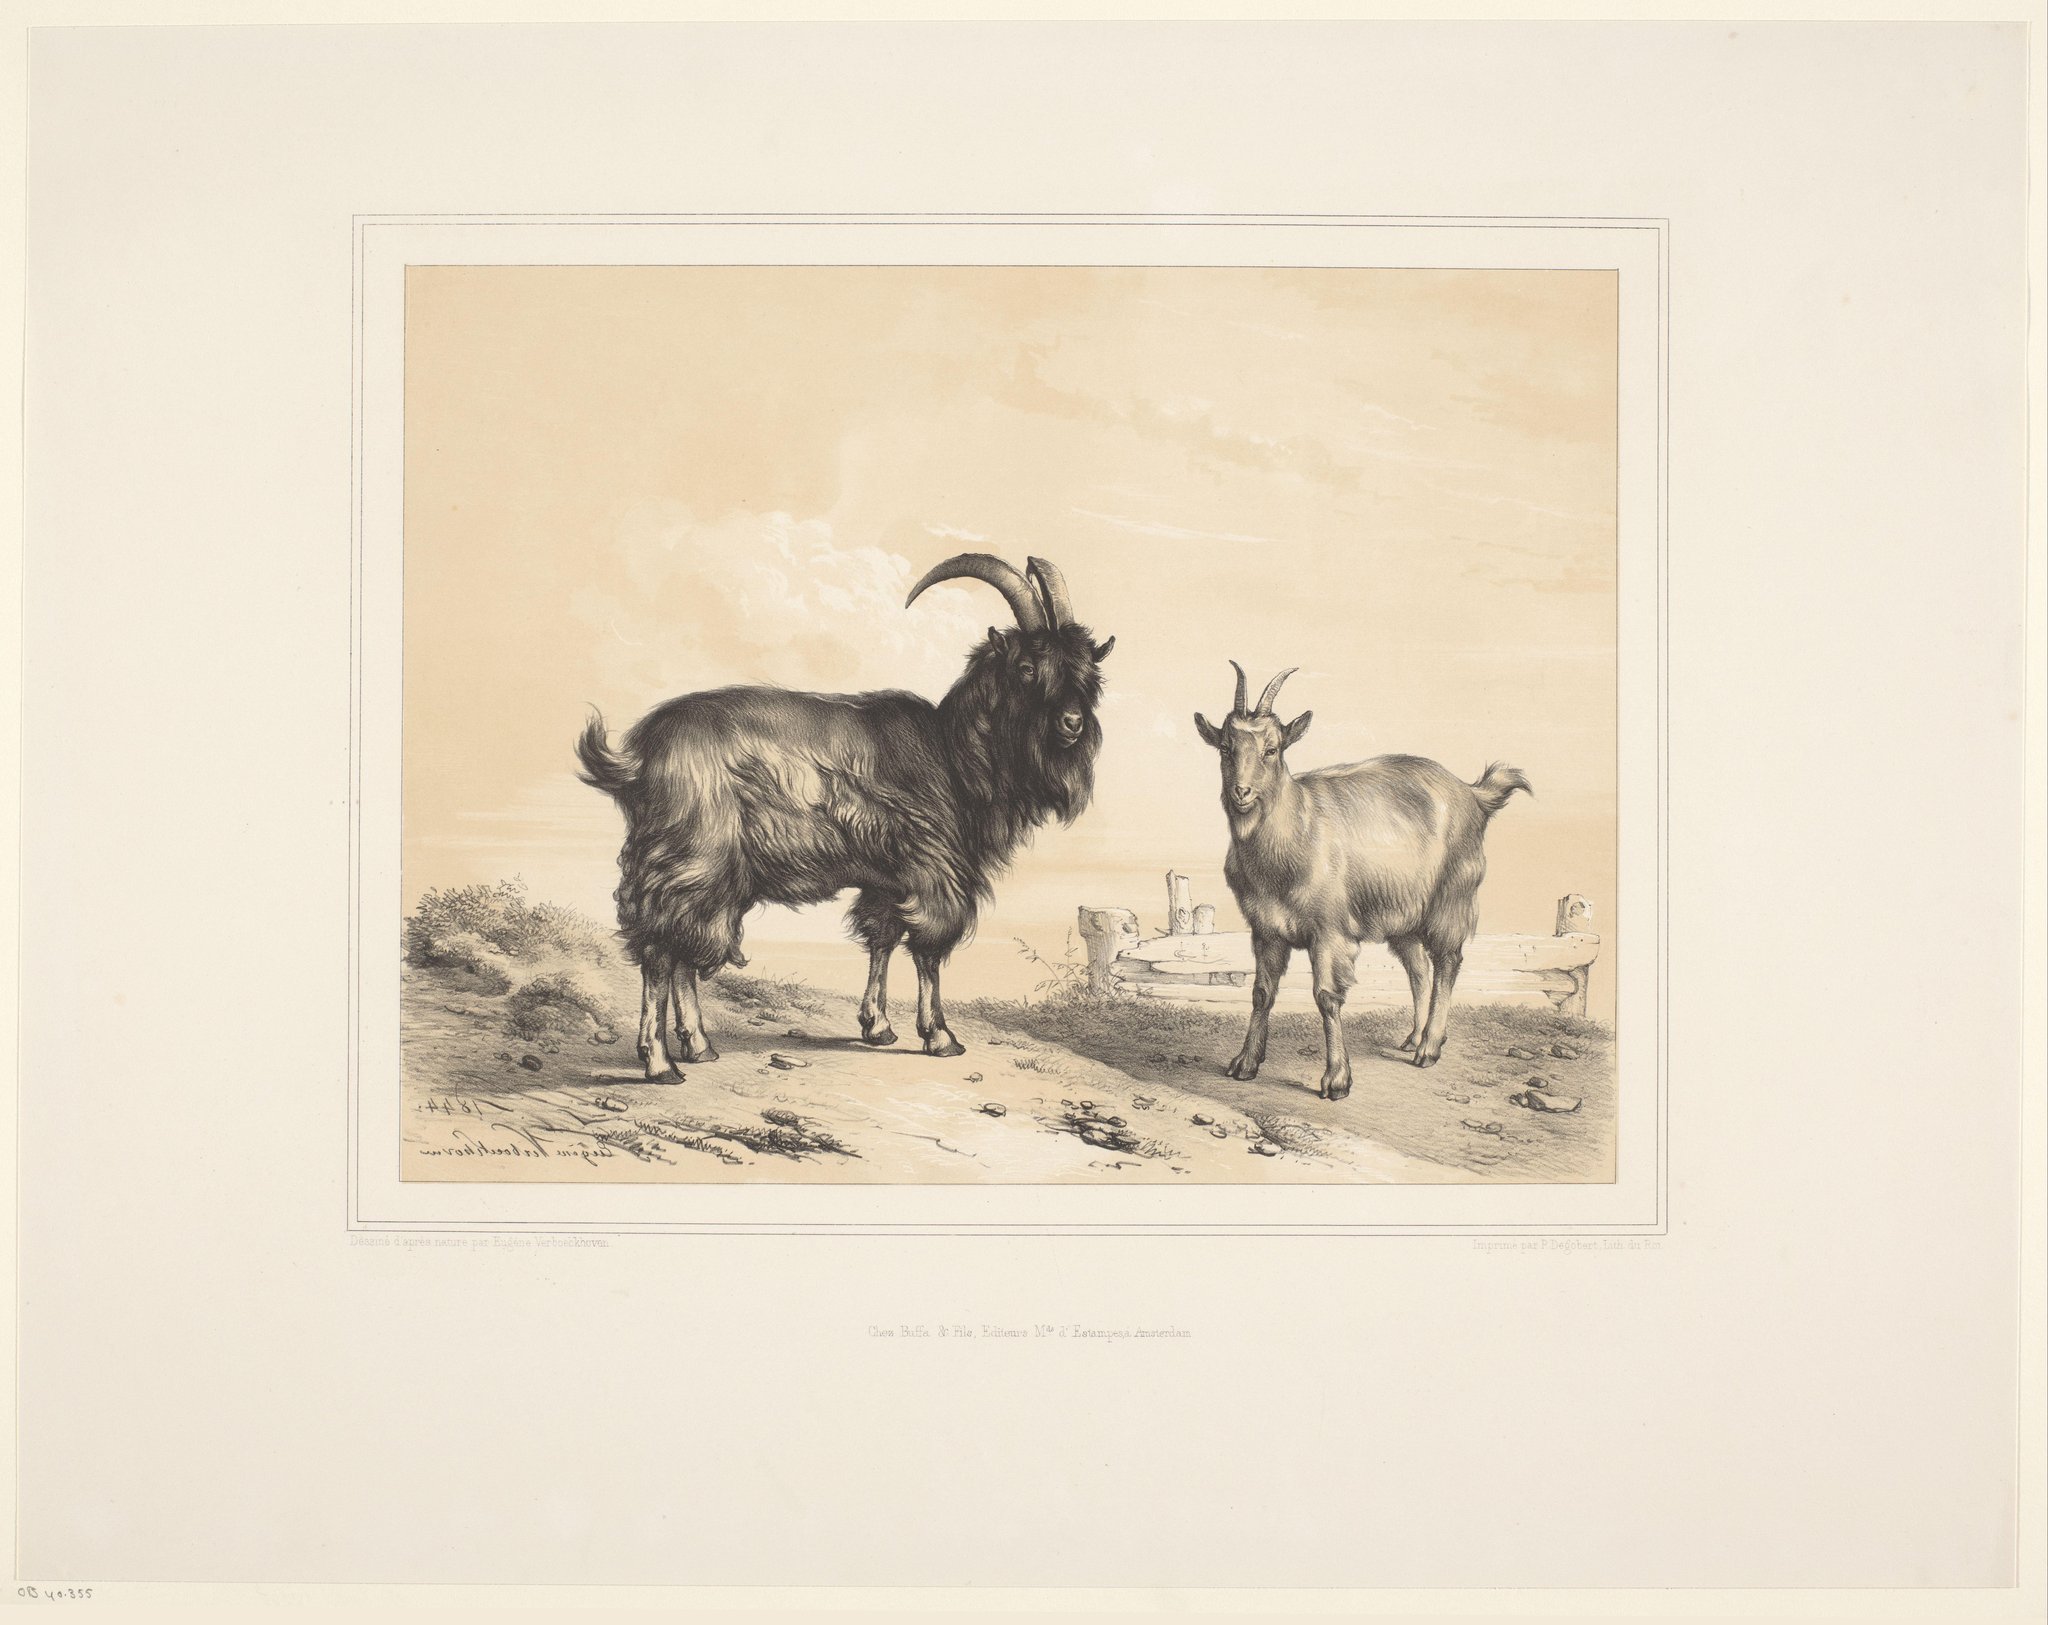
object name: print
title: Études d'Animaux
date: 1844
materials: paper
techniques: tone lithography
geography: amsterdam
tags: goat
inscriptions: collector's mark: Lugt 2228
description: Prent maakt deel uit van een serie van dertien prenten.